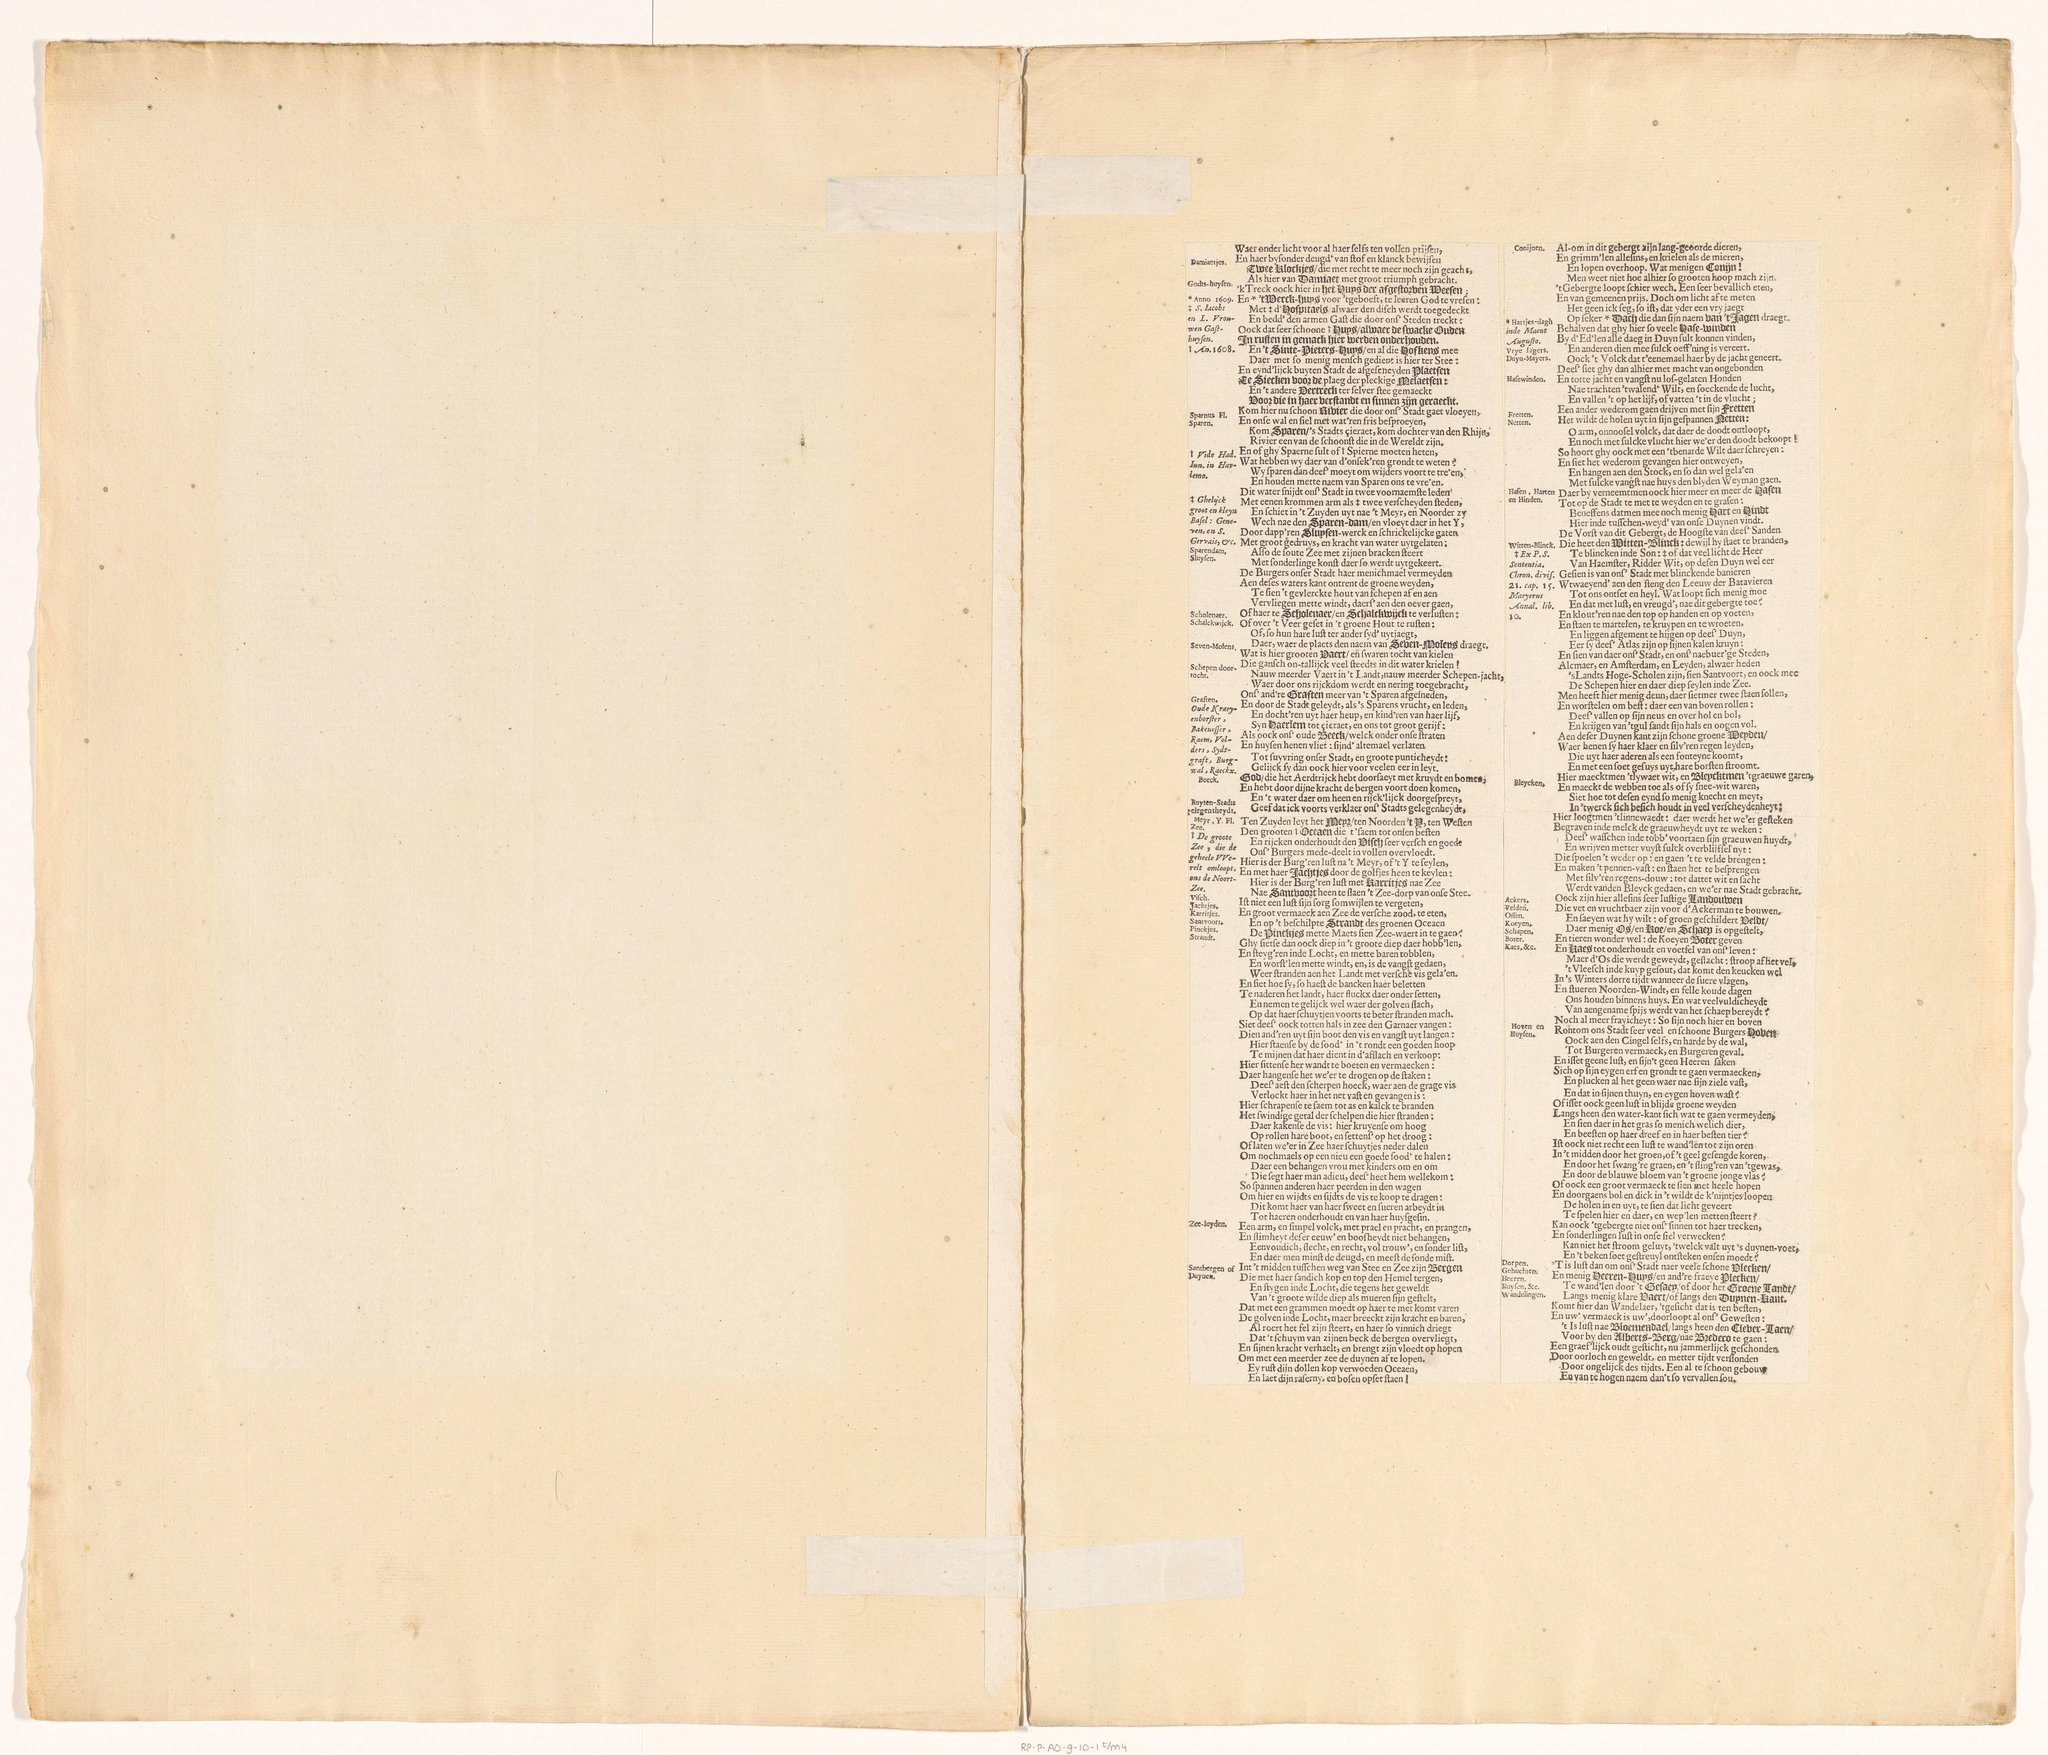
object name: text sheet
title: Deel van een beschrijving van de stad Haarlem in dichtvorm (3/4)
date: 1641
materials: paper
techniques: letterpress printing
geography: amsterdam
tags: haarlem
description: Blad (derde van vier) met een beschrijving van de stad Haarlem in dichtvorm.